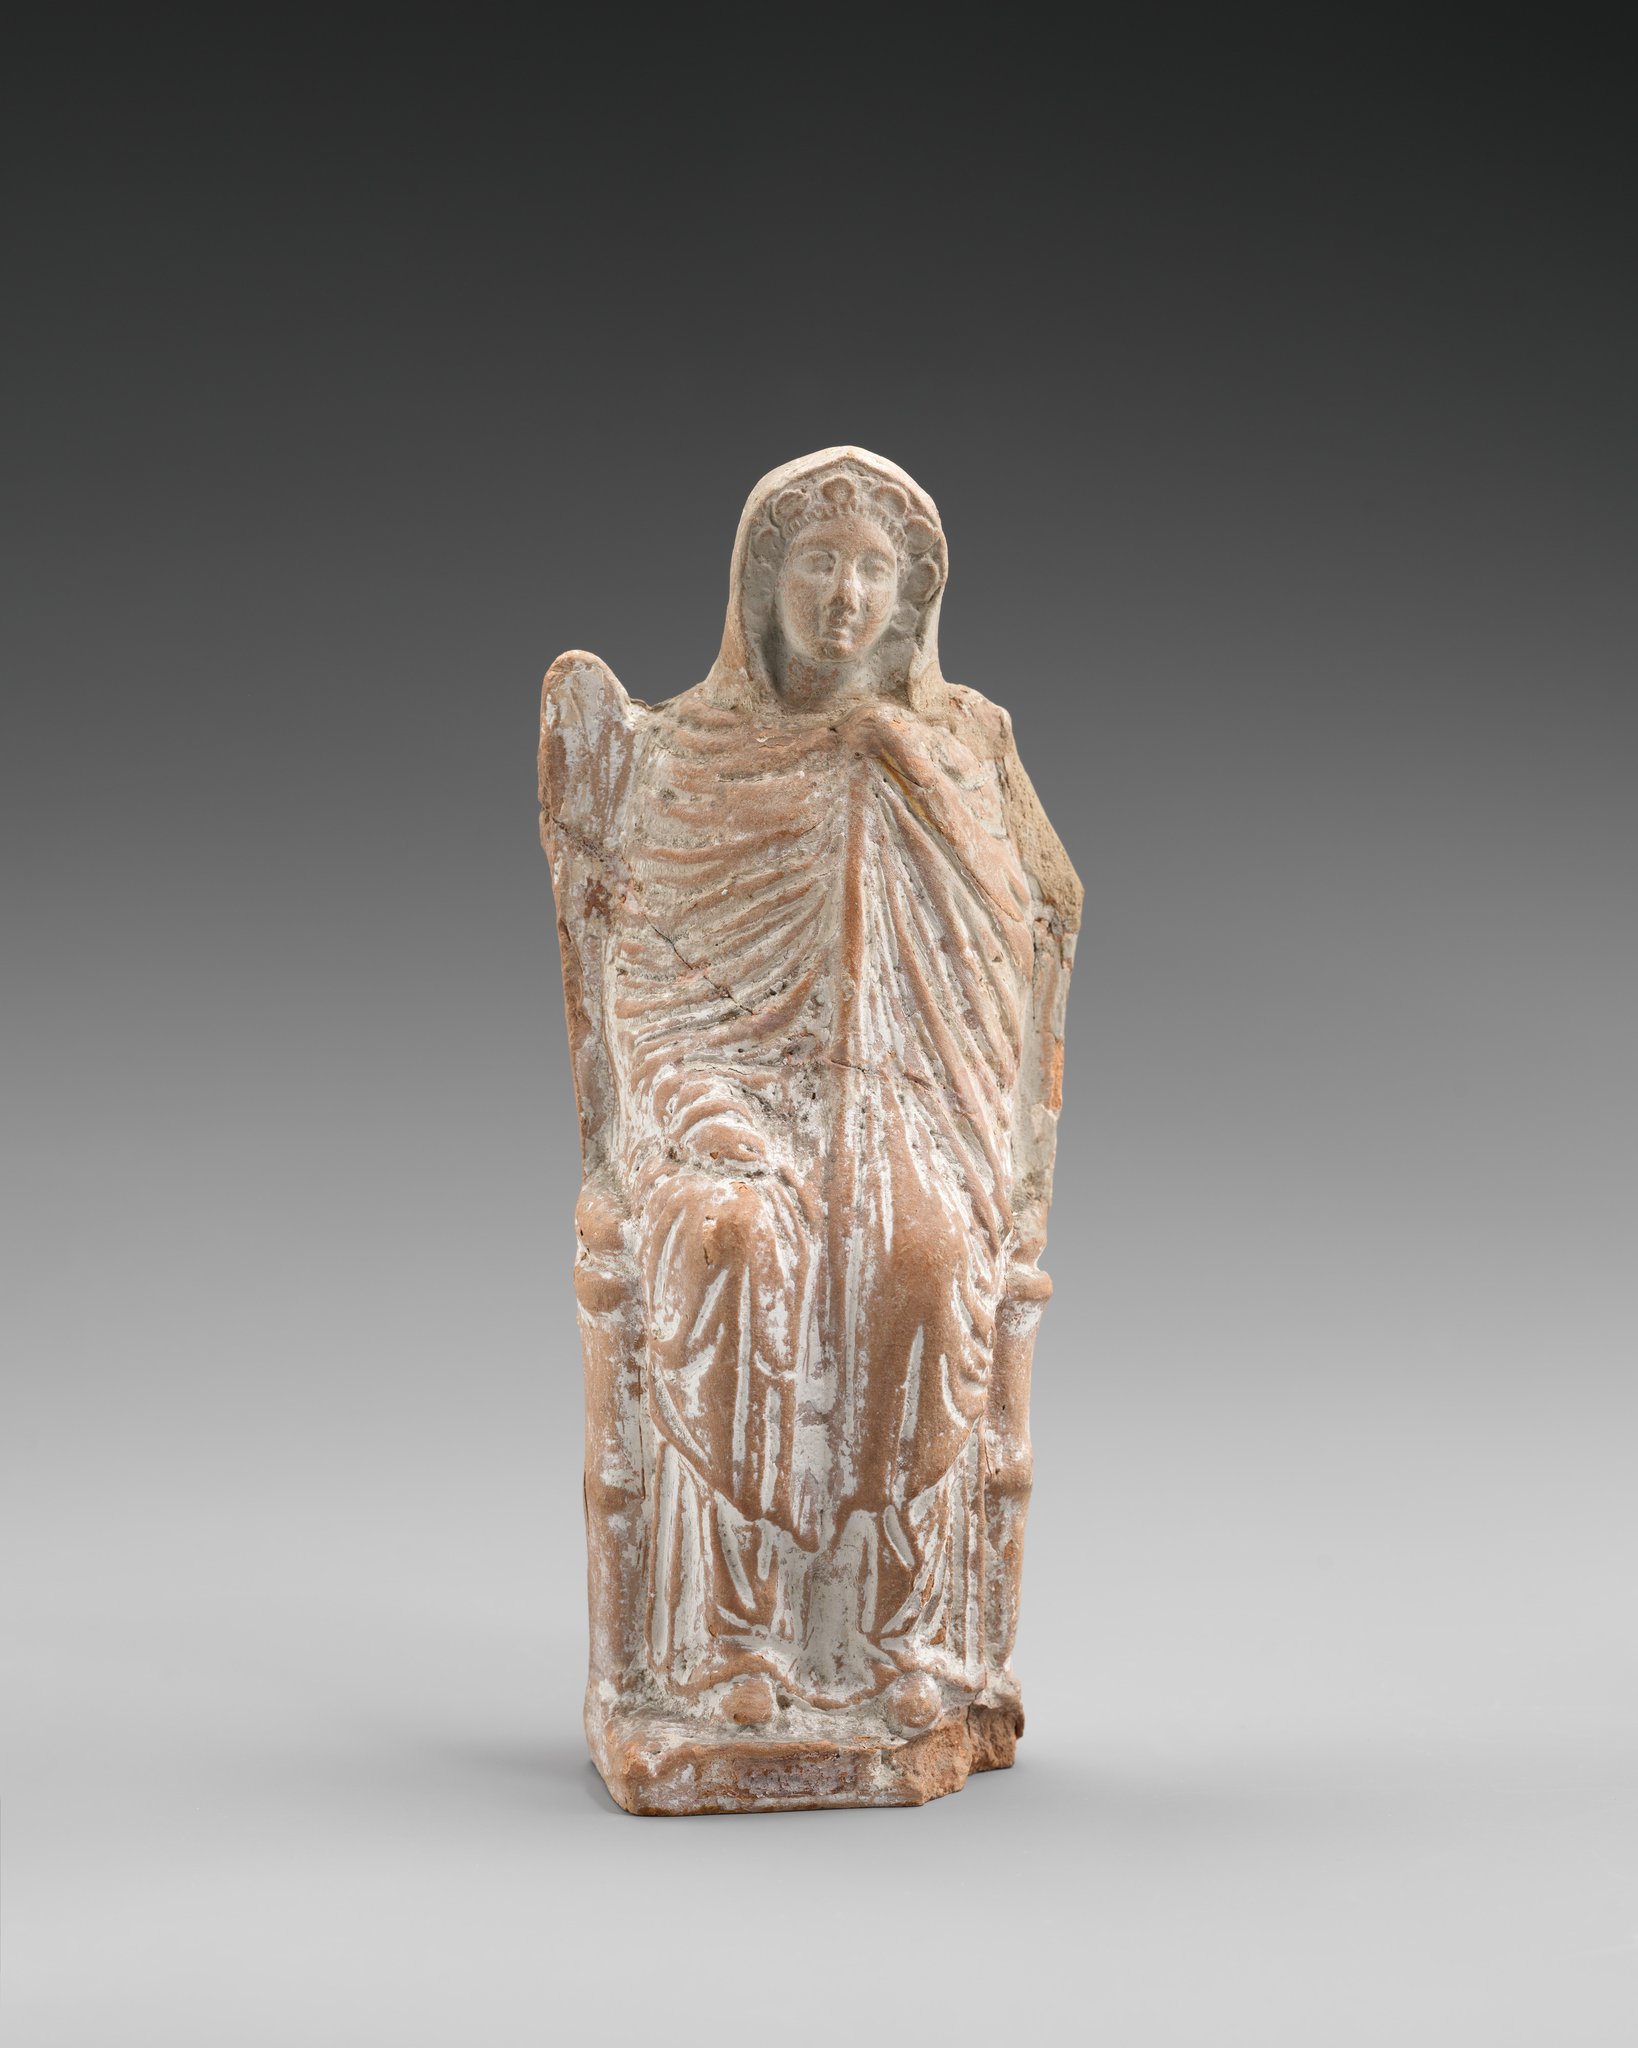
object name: statuette of a seated goddess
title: Terracotta statuette of a seated goddess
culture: cypriot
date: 334-268 BCE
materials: terracotta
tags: goddess